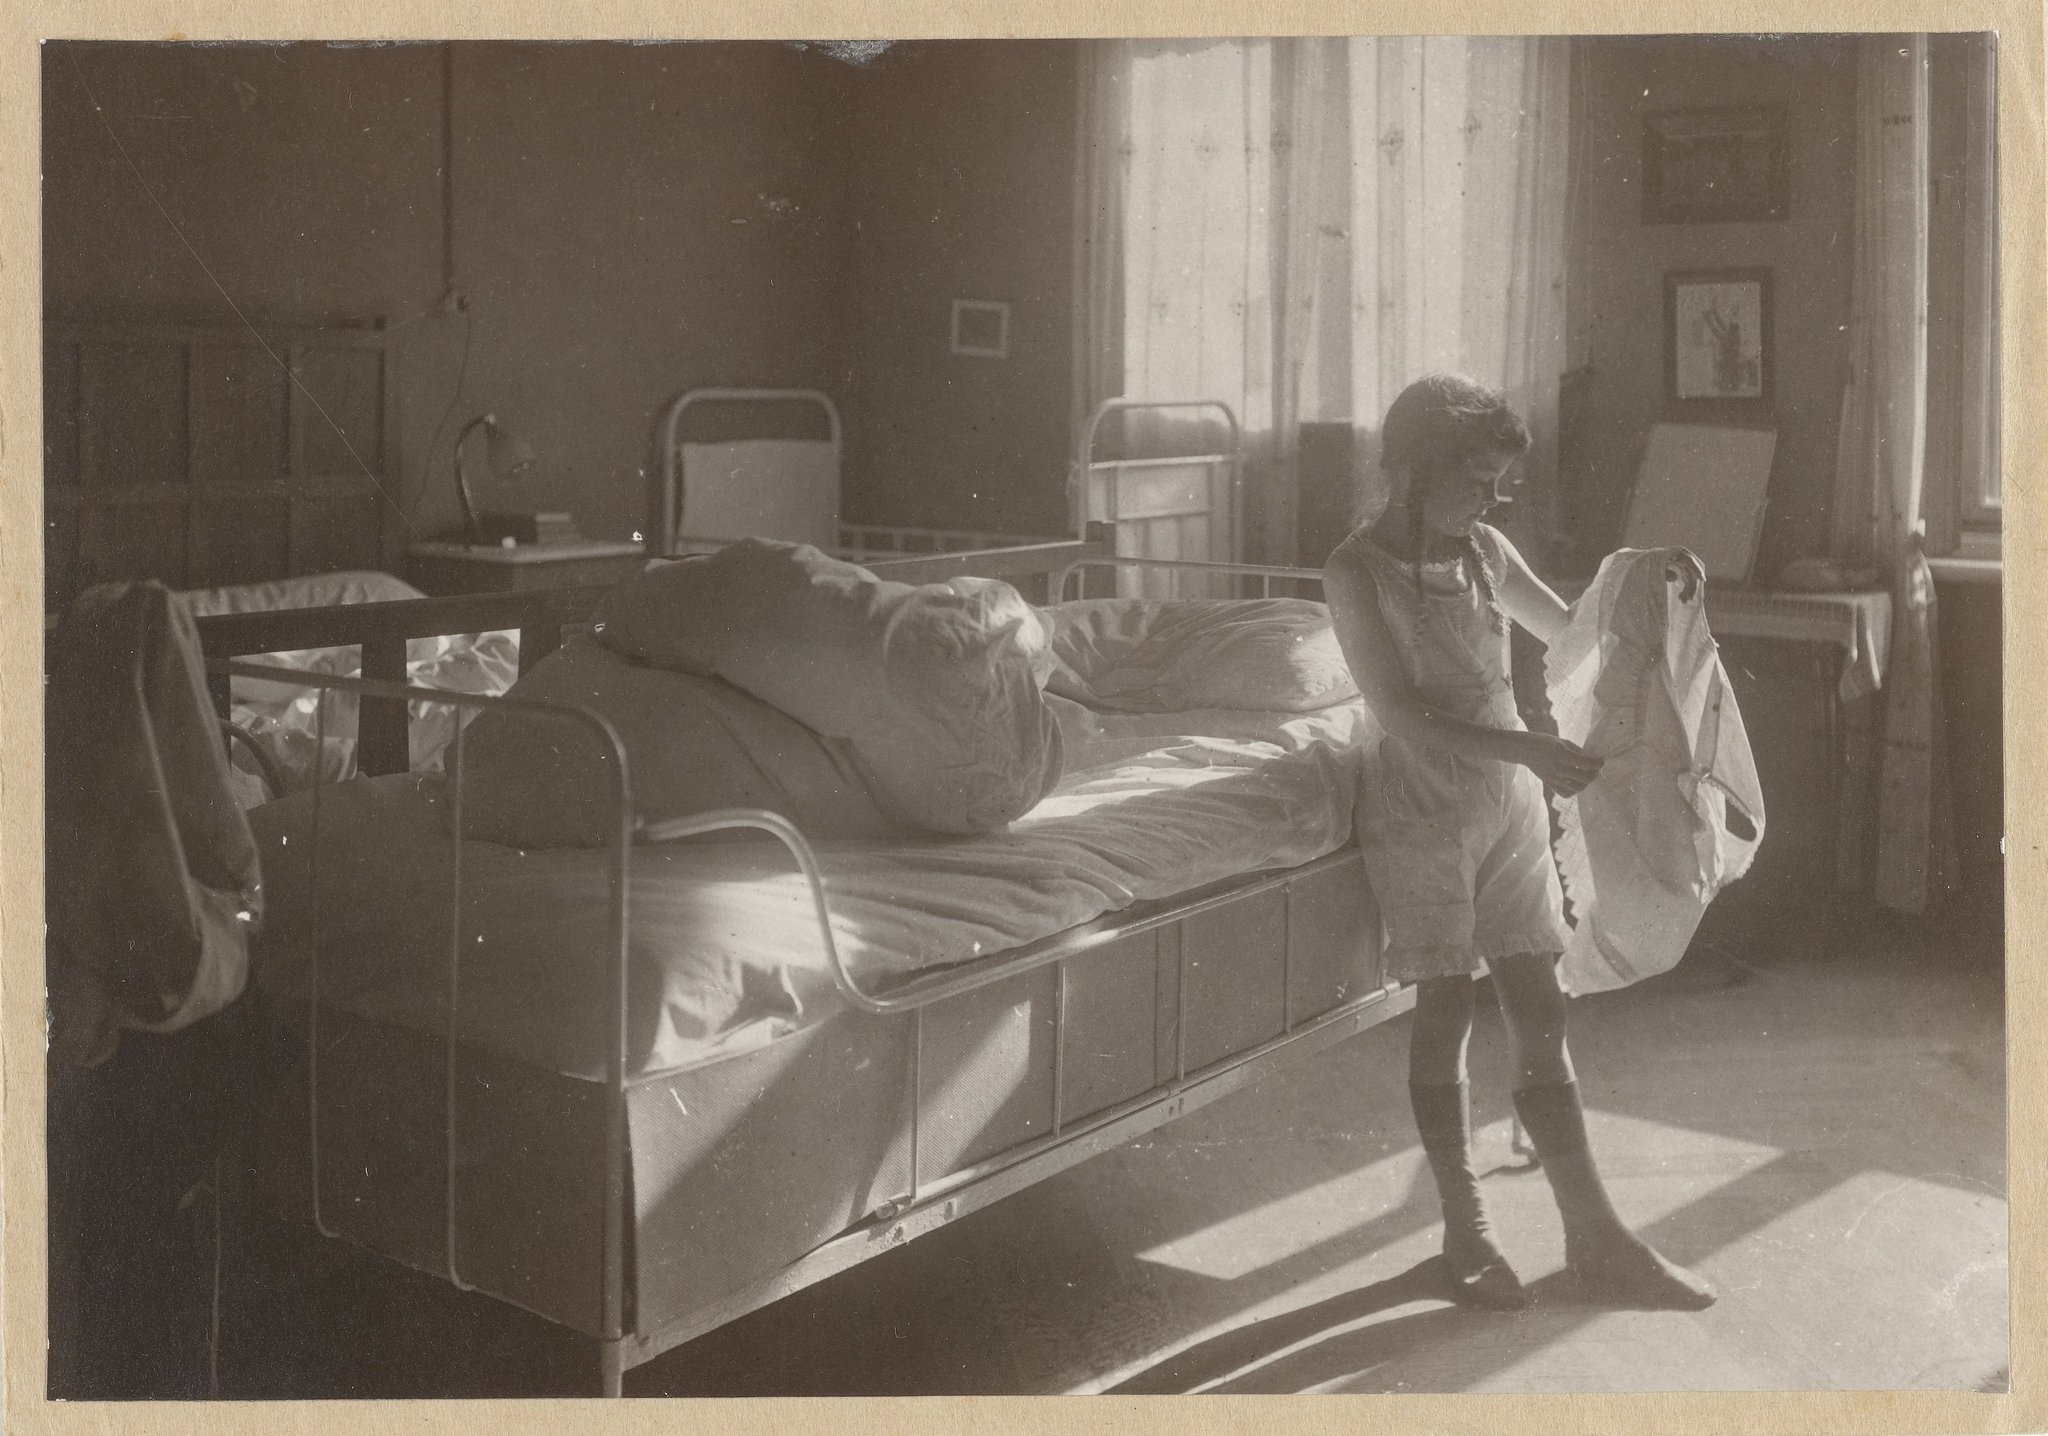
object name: photograph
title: Marba Titzenthaler, dochter van de fotograaf, in de slaapkamer van het woonhuis in de Friedrichstrasse, Berlijn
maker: waldemar titzenthaler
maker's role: fotograaf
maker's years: 1869-1937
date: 1917-1918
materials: paper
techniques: gelatin silver print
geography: berlin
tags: girl (child between toddler and youth), bedroom, berlin